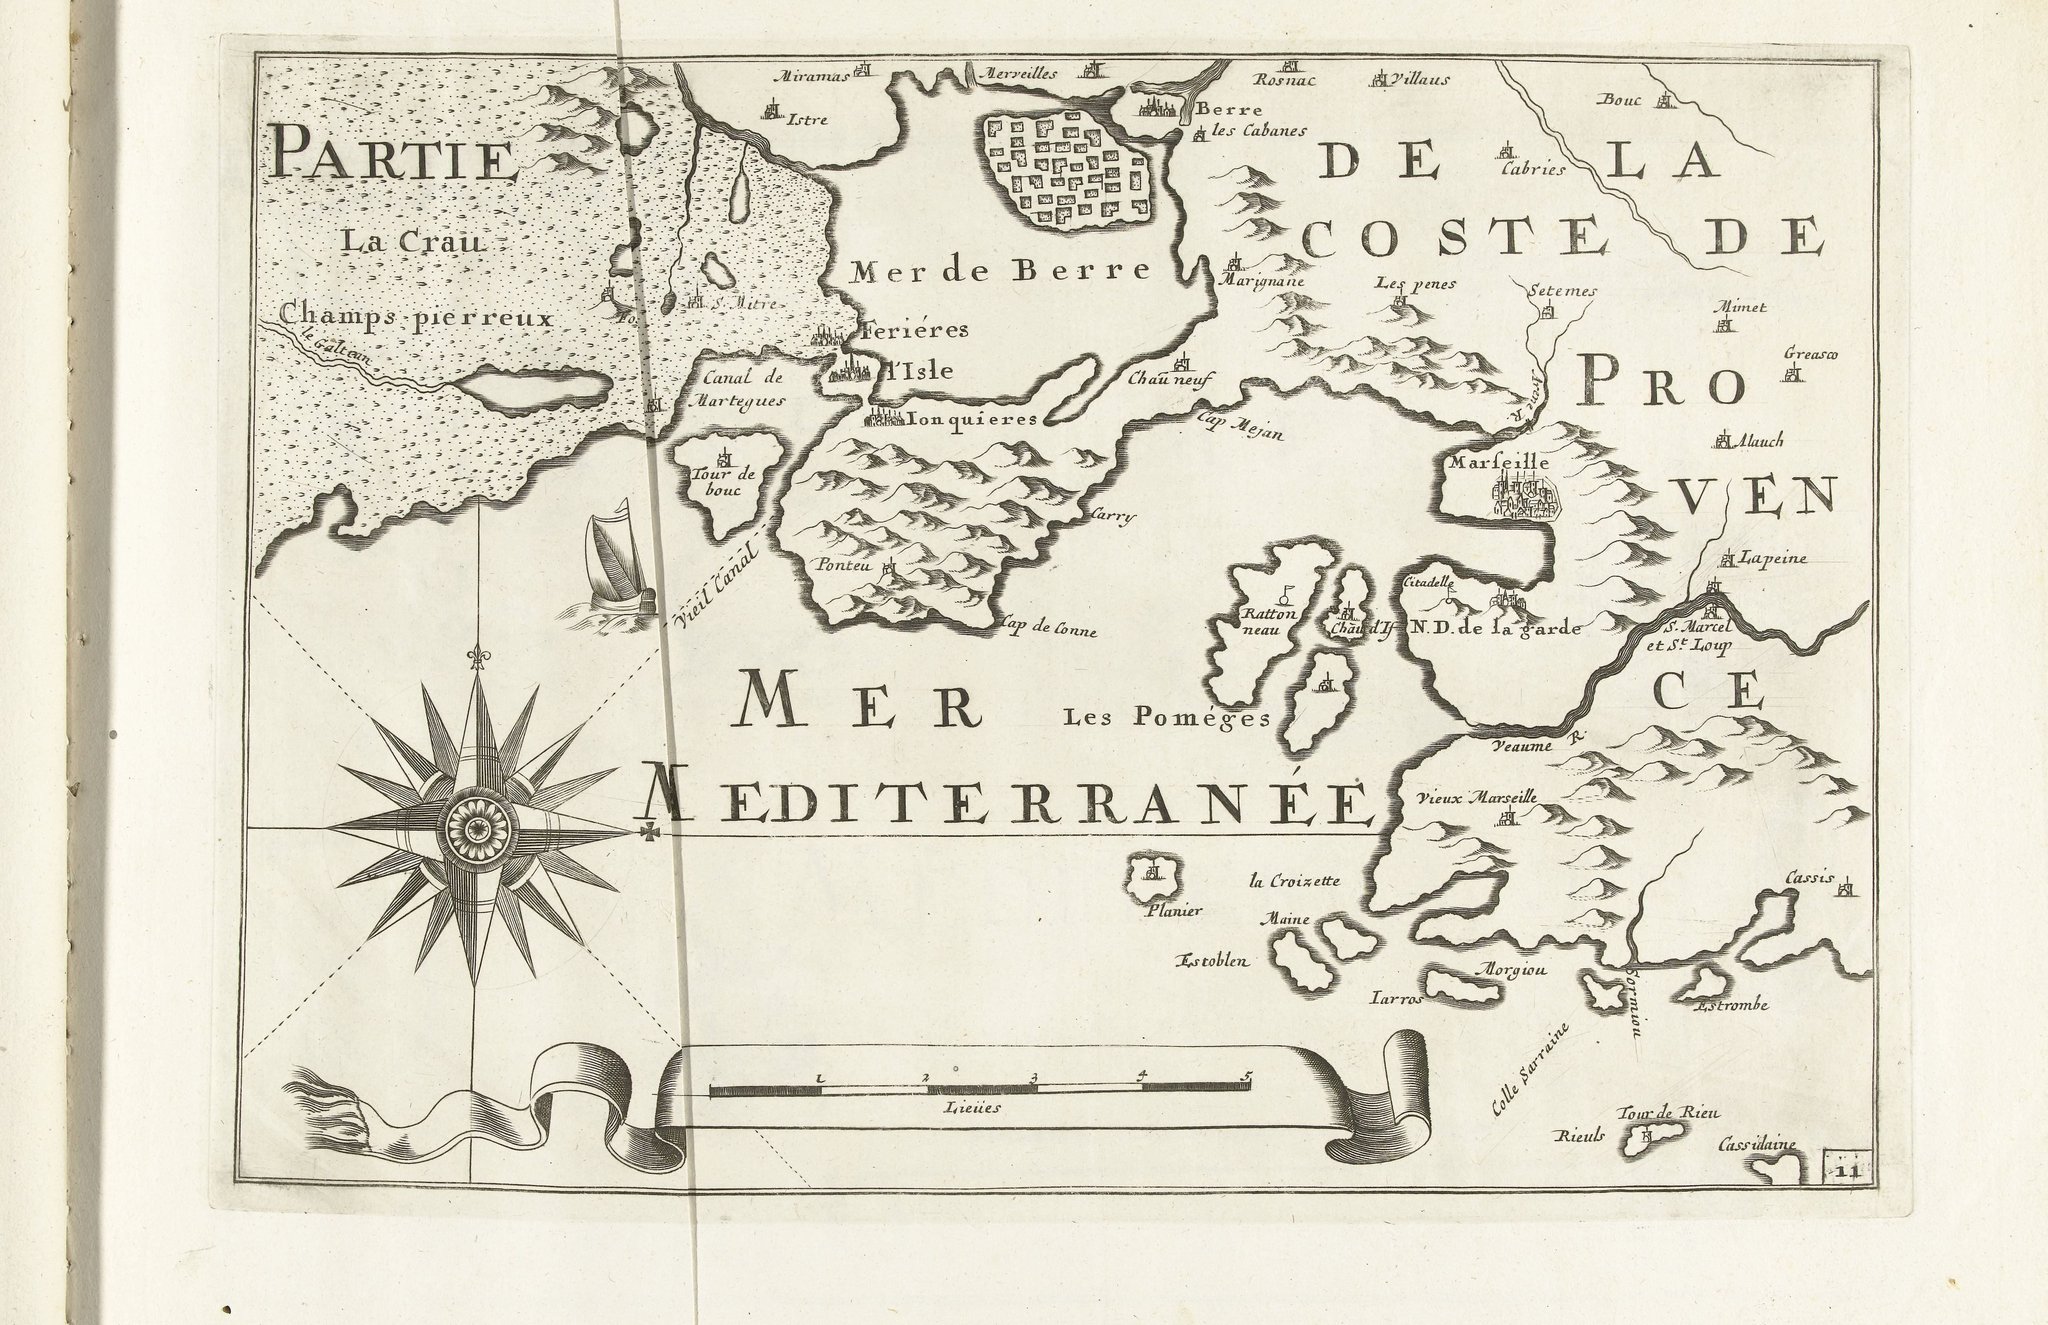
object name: print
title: Kaart van de Franse zuidkust bij Marseille, ca. 1702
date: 1702-1703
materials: paper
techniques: engraving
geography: northern netherlands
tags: maps of separate countries or regions, france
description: Kaart van de Franse zuidkust bij Marseille. Gemerkt rechtsonder: ii. Onderdeel van het tweede van twee delen van het prentwerk: Les costes de France et d'Espagne (oftewel deel 14 van: Les Forces de l'Europe, Asie, Afrique et Amerique), uitgegeven ca. 1702. Het prentwerk bestaat in totaal uit 43 gemerkte platen van de kust van Frankrijk en Spanje, in het kader van de Spaanse Successieoorlog. Deze platen zijn gekopieerd naar anonieme Franse platen oorspronkelijk uitgegeven door Nicolas de Fer te Parijs. Titel en opschriften in de plaat in het Frans.